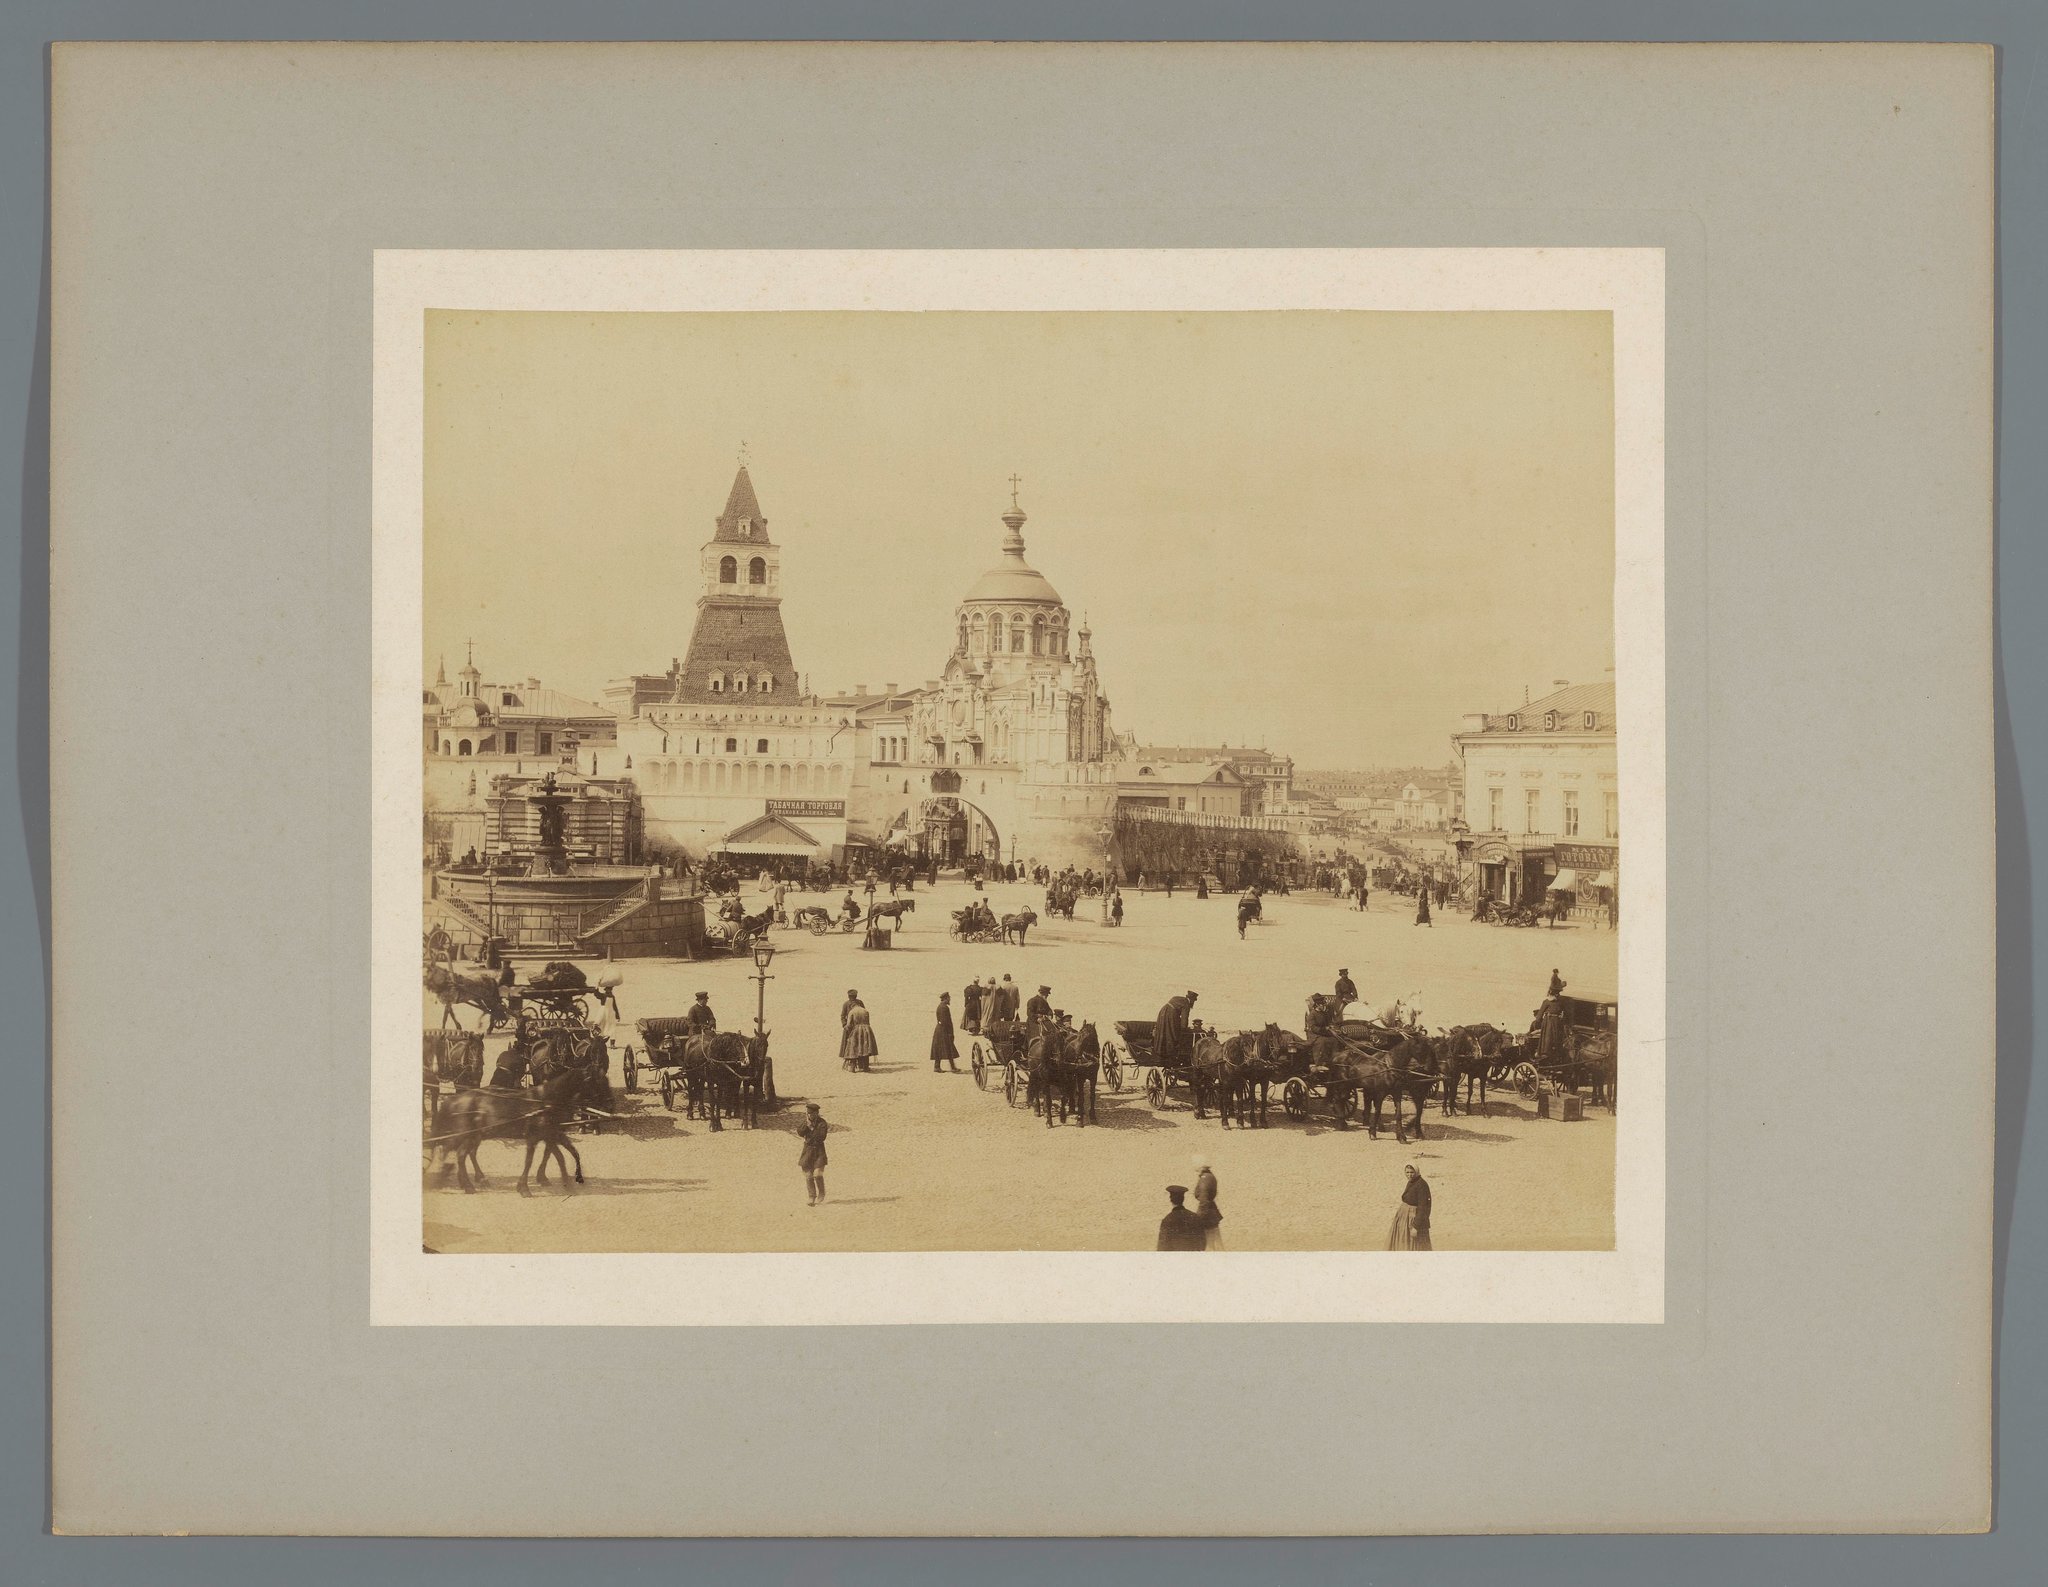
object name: photograph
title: Dserjinski Plein en Wladimir Toren, Moskou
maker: Anonymous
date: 1860-1890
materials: cardboard, paper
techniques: albumen print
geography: moscow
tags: square, place, circus, etc.